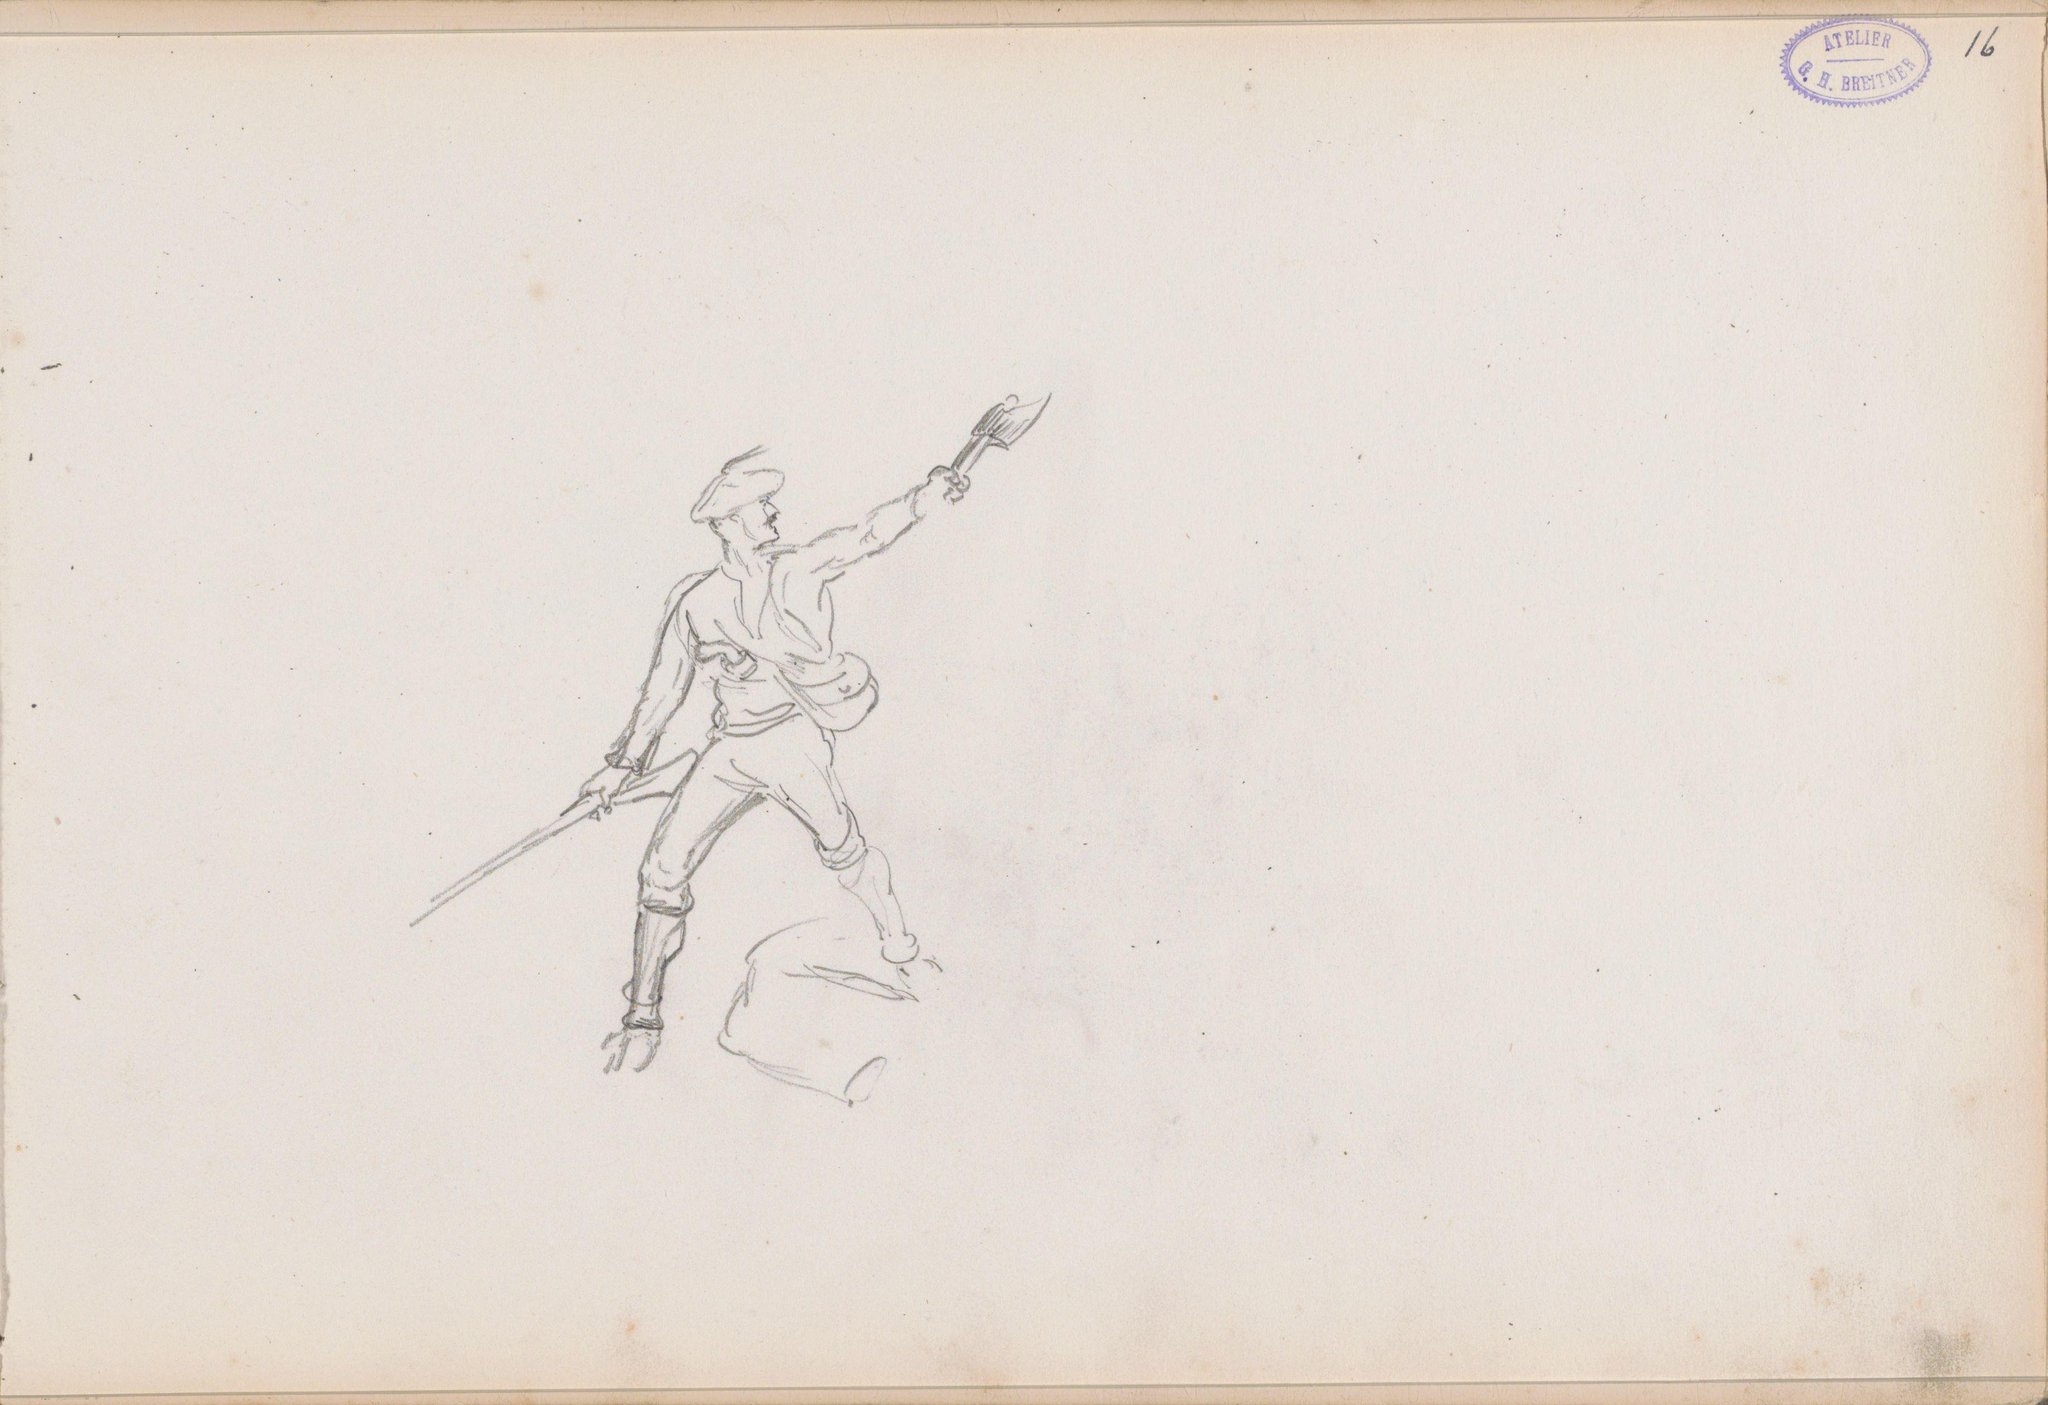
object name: sketchbook leaf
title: Soldaat met geweer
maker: george hendrik breitner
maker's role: draughtsman, painter, print maker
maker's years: 1857-1923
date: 1809-1872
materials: paper, pencil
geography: rotterdam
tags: firearms: rifle, division of armed forces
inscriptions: workshop stamp: Lugt 291d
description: Blad 16 uit een schetsboek met 32 bladen.